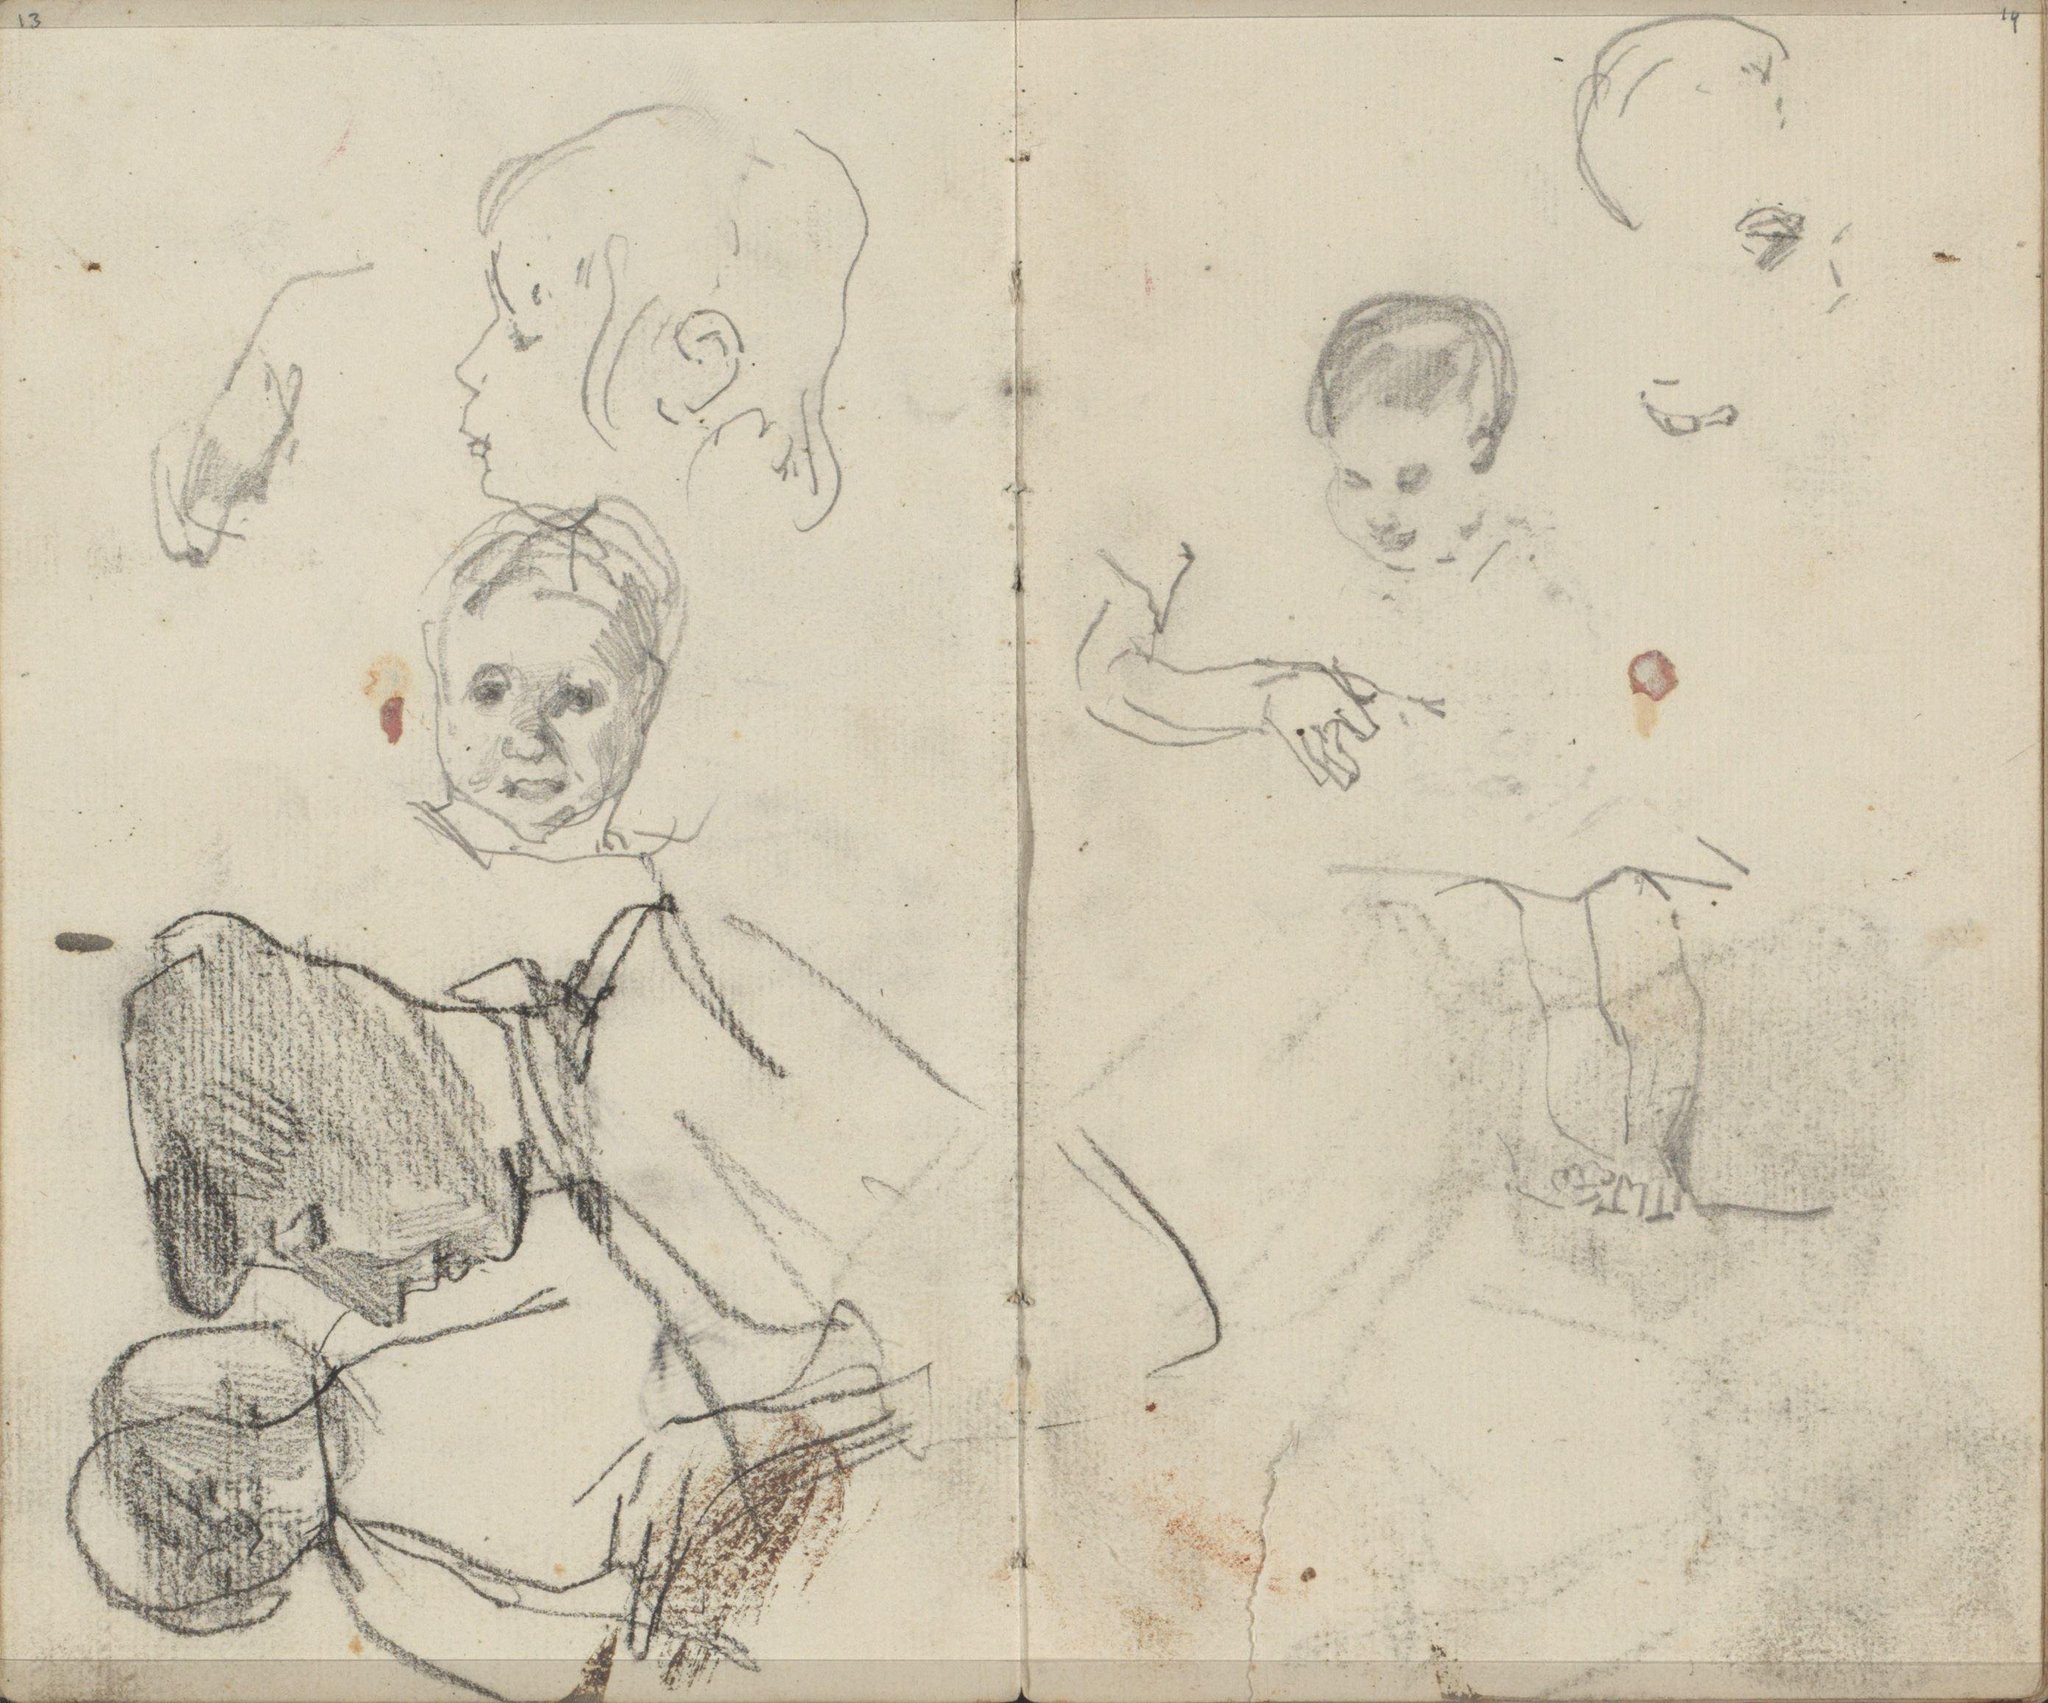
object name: sketchbook leaf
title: Studieblad met een vrouw en kinderen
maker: george hendrik breitner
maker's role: draughtsman, painter, print maker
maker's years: 1857-1923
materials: chalk, paper, pencil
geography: the hague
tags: child, adult woman (+ sideview, profile)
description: Pagina 13 en pagina 14 uit een schetsboek met 28 bladen.